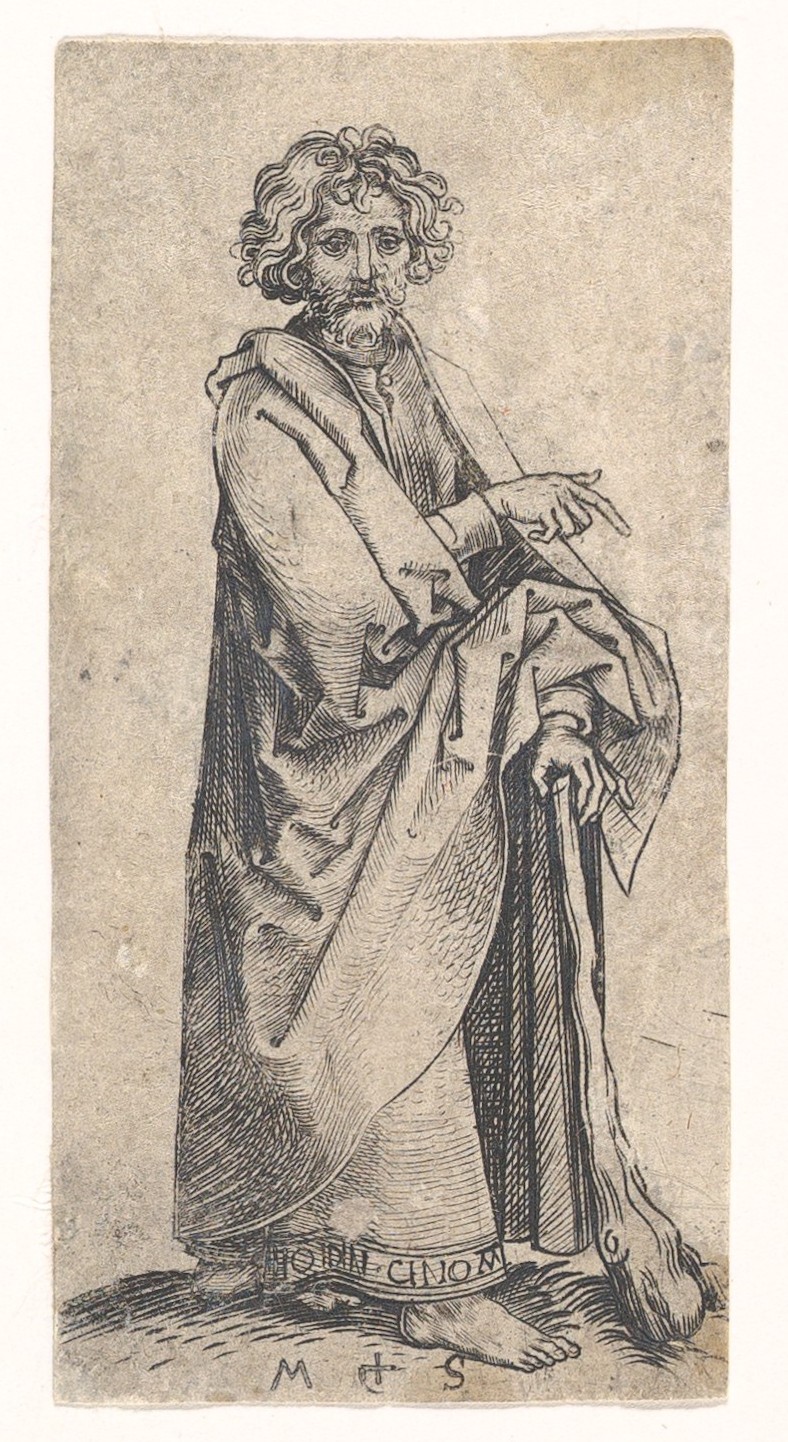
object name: print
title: St. James the Less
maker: martin schongauer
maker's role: artist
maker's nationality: german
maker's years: 1430-1491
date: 1470-1491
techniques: engraving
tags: saints